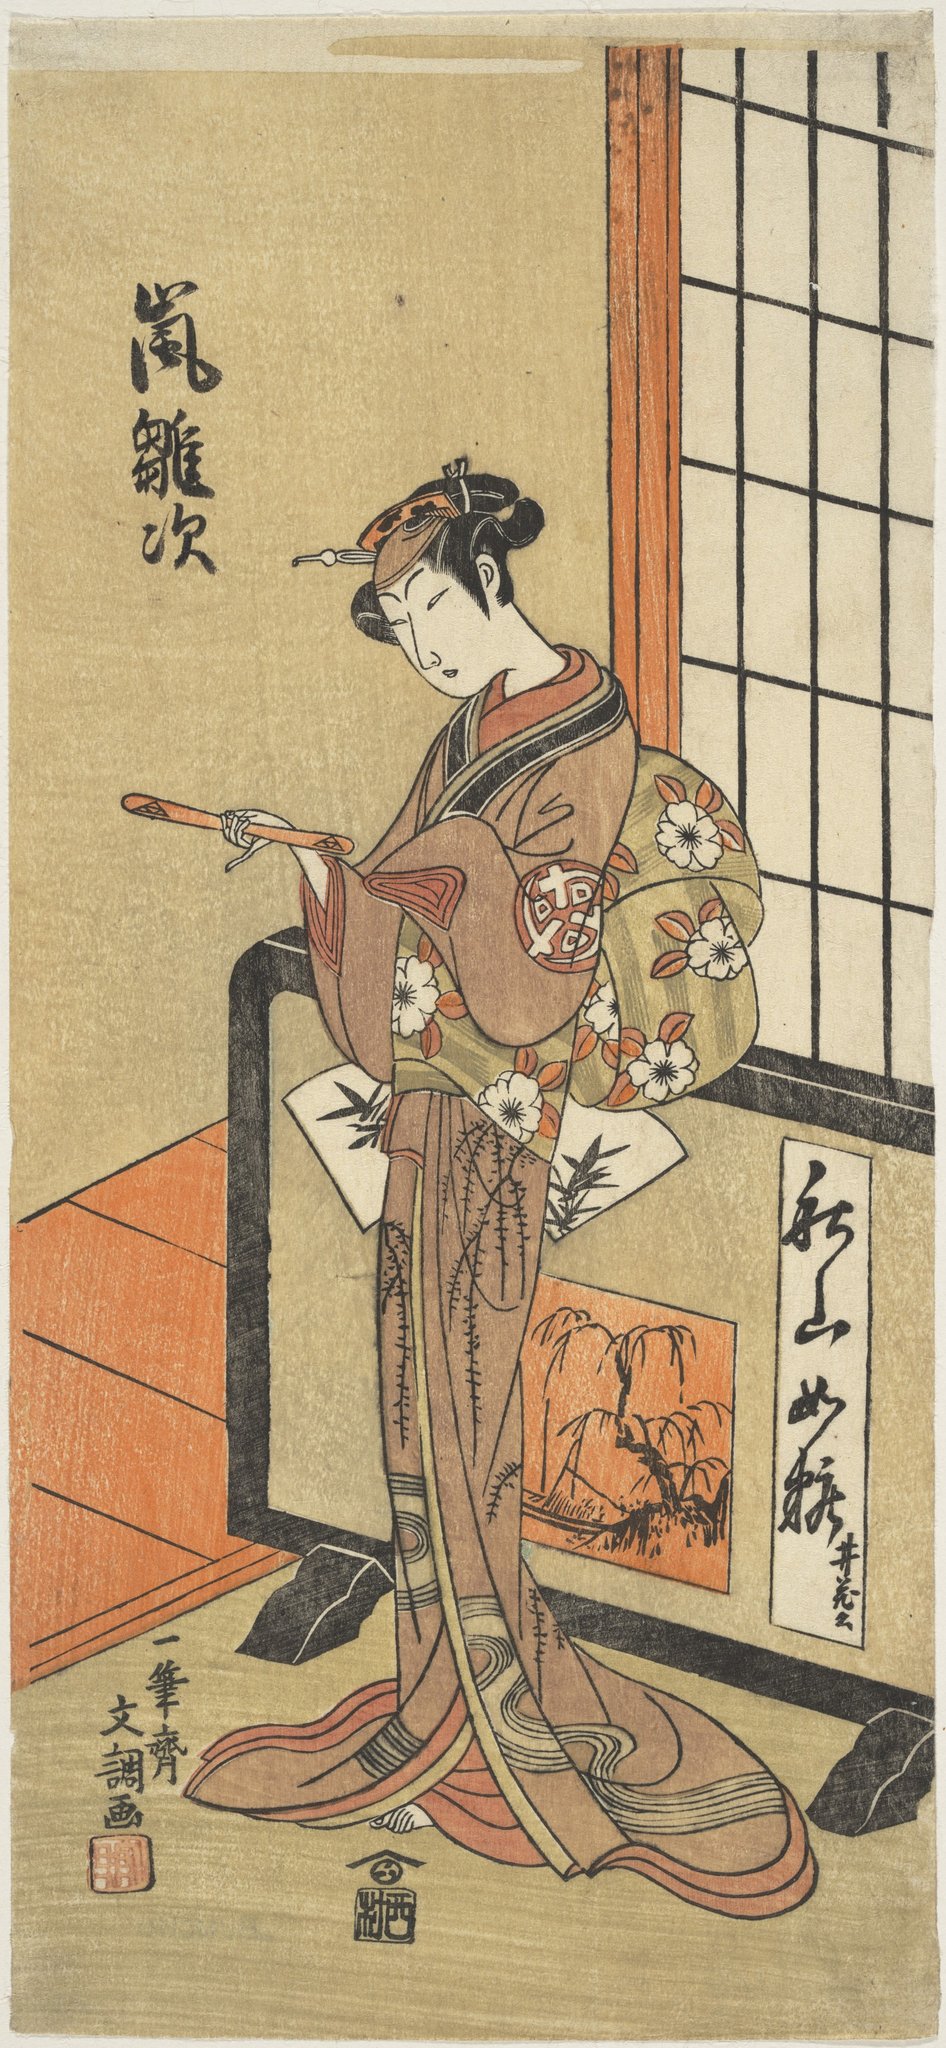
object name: print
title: The Actor Arashi Hinaji in a Female Role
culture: japanese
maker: ippitsusai bunchō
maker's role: artist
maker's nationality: japanese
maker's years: 1765-1792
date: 1770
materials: ink, paper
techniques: woodblock print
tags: women,actors